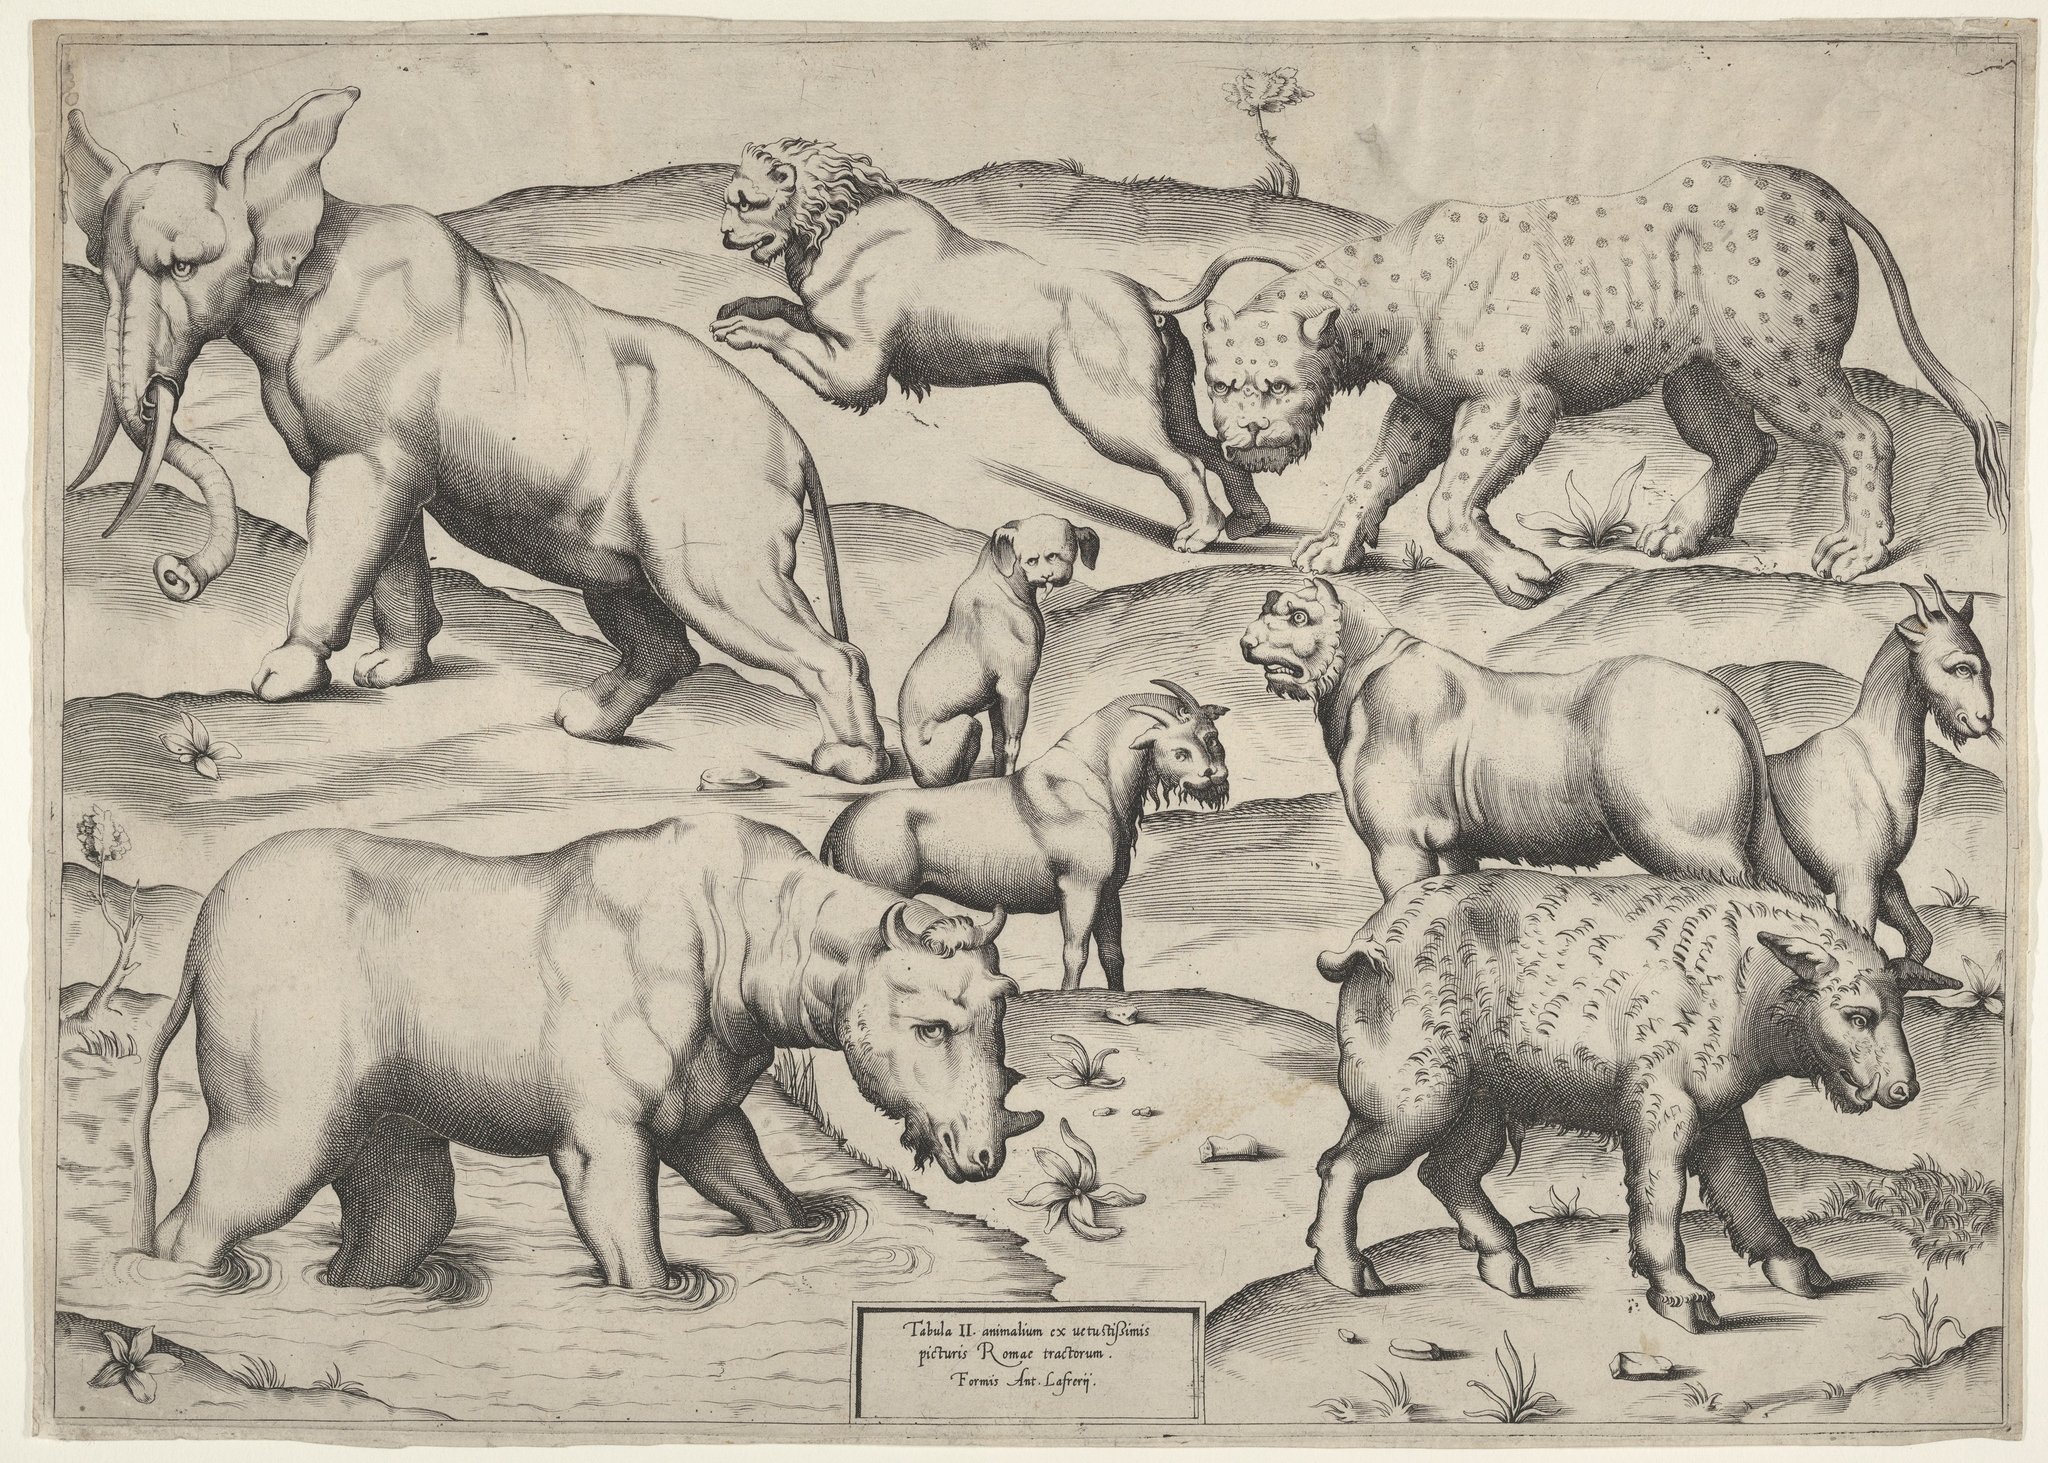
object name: print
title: Various Animals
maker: anonymous, italian, 16th century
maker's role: artist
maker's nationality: italian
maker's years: 1500-1600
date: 1540-1600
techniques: engraving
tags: animals